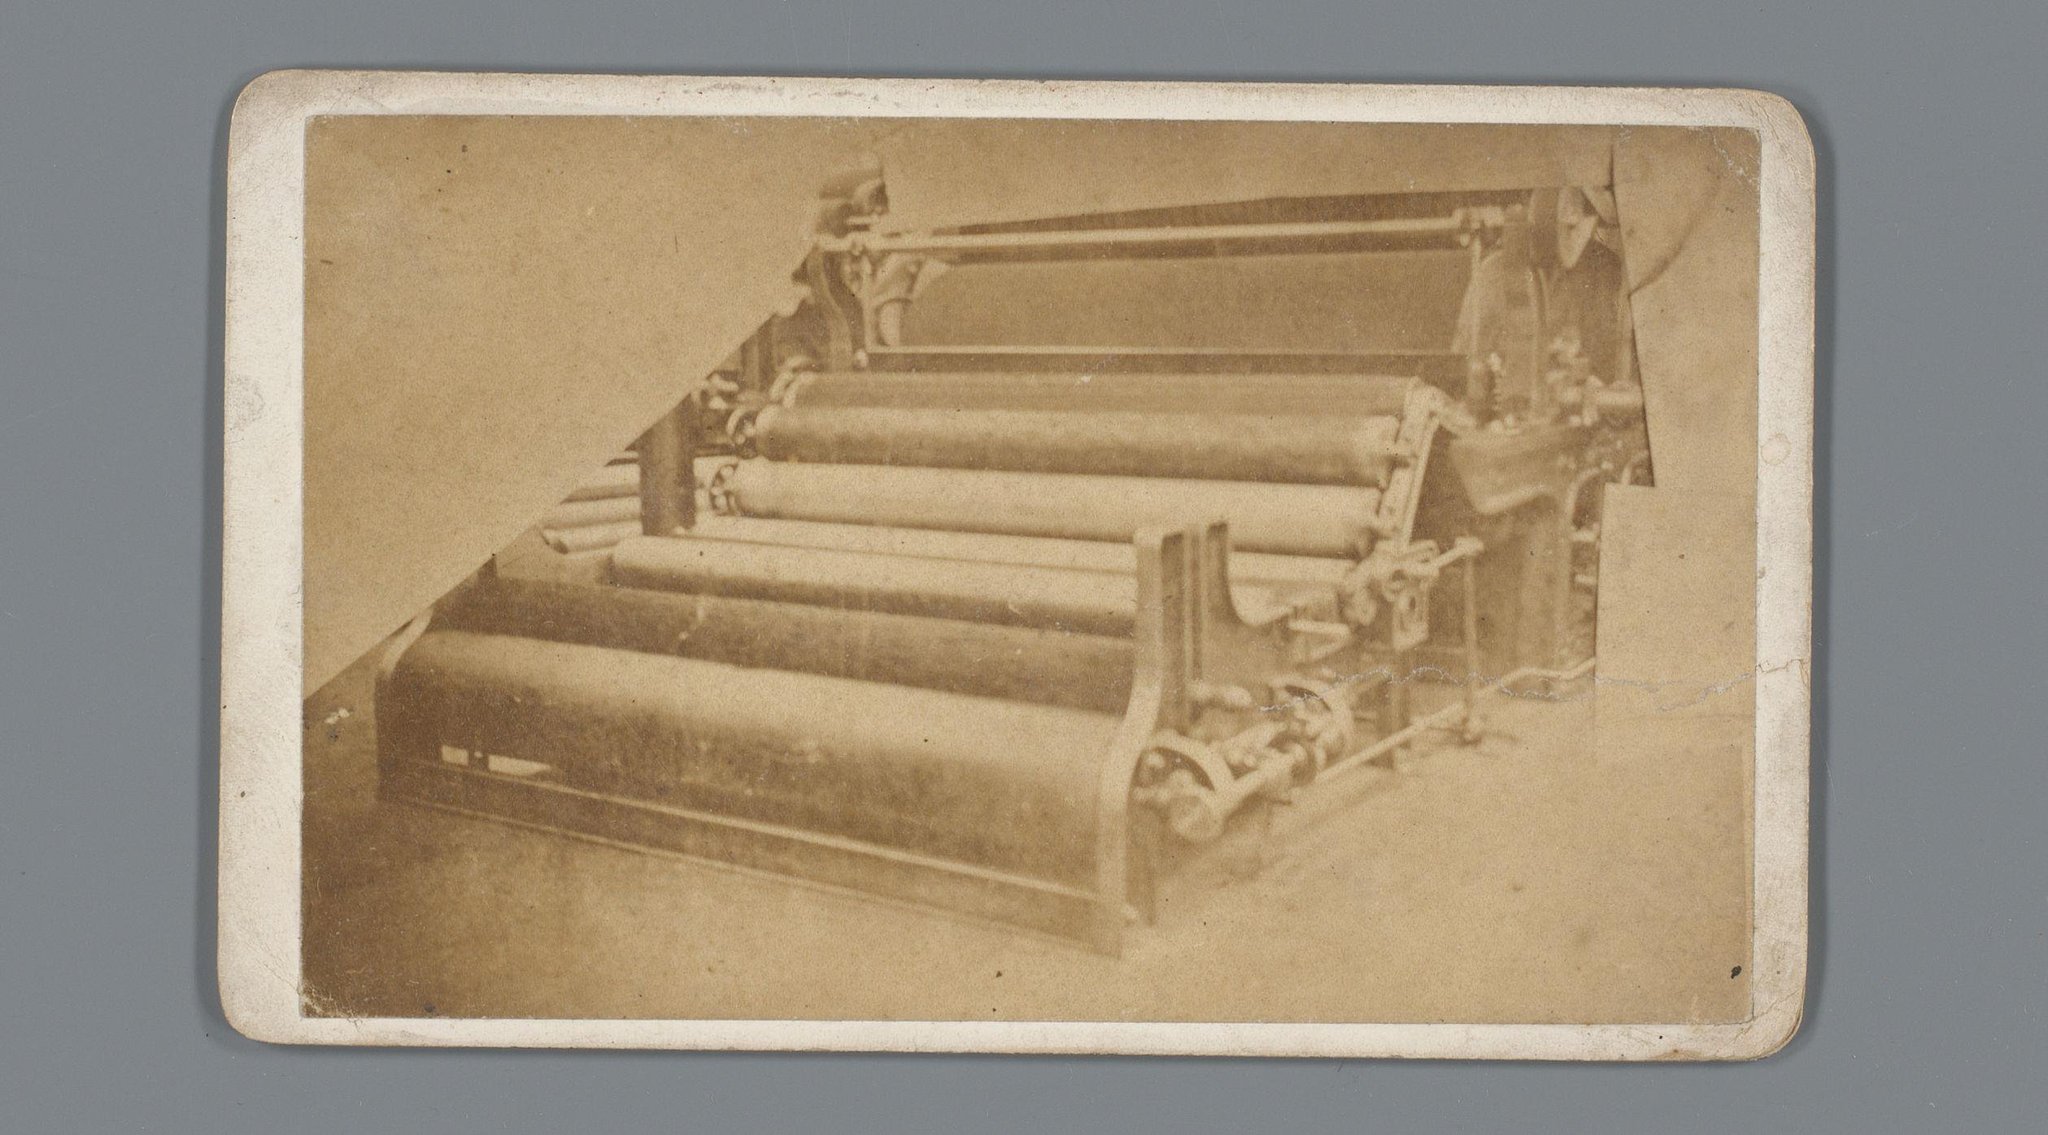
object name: photograph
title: Gezicht op een machine, vermoedelijk een drukpers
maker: Anonymous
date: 1850-1915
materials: cardboard, photographic support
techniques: albumen print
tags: machines; parts of machines; tools and appliances, printing press